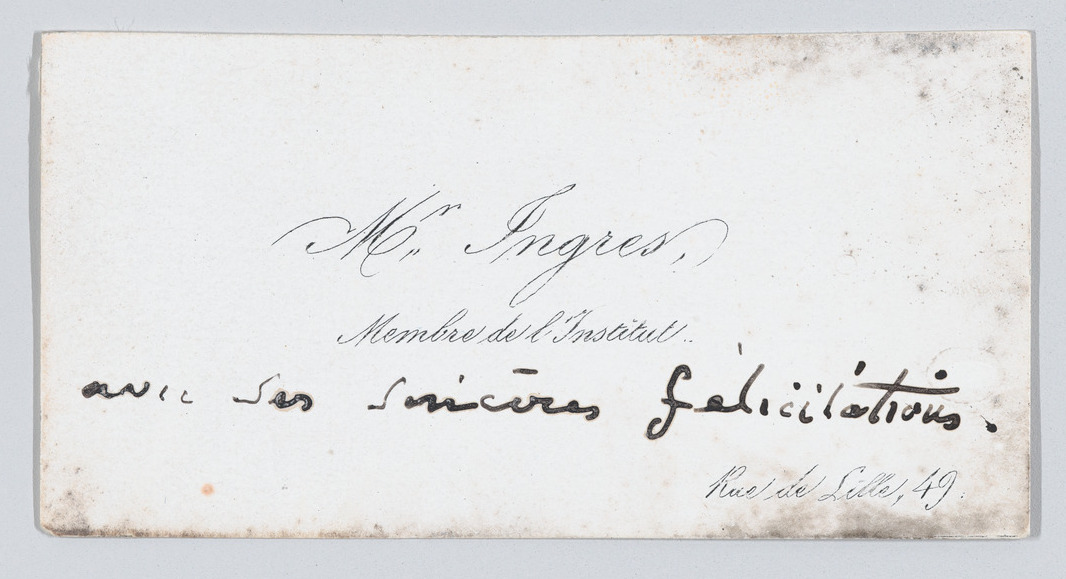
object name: print, calling card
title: J.A.D. Ingres, calling card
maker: Anonymous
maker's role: artist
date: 1824-1867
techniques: engraving